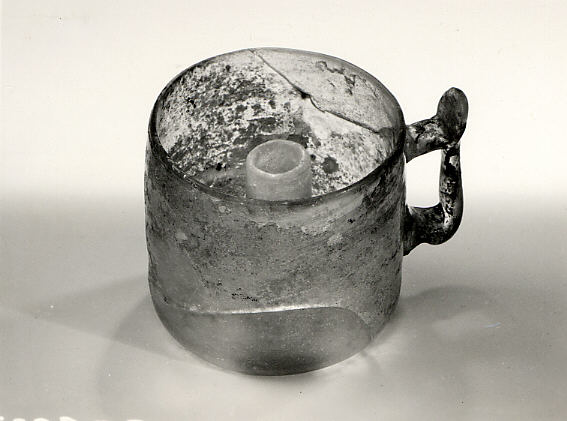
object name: lamp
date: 801-900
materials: glass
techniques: glassblowing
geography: iran